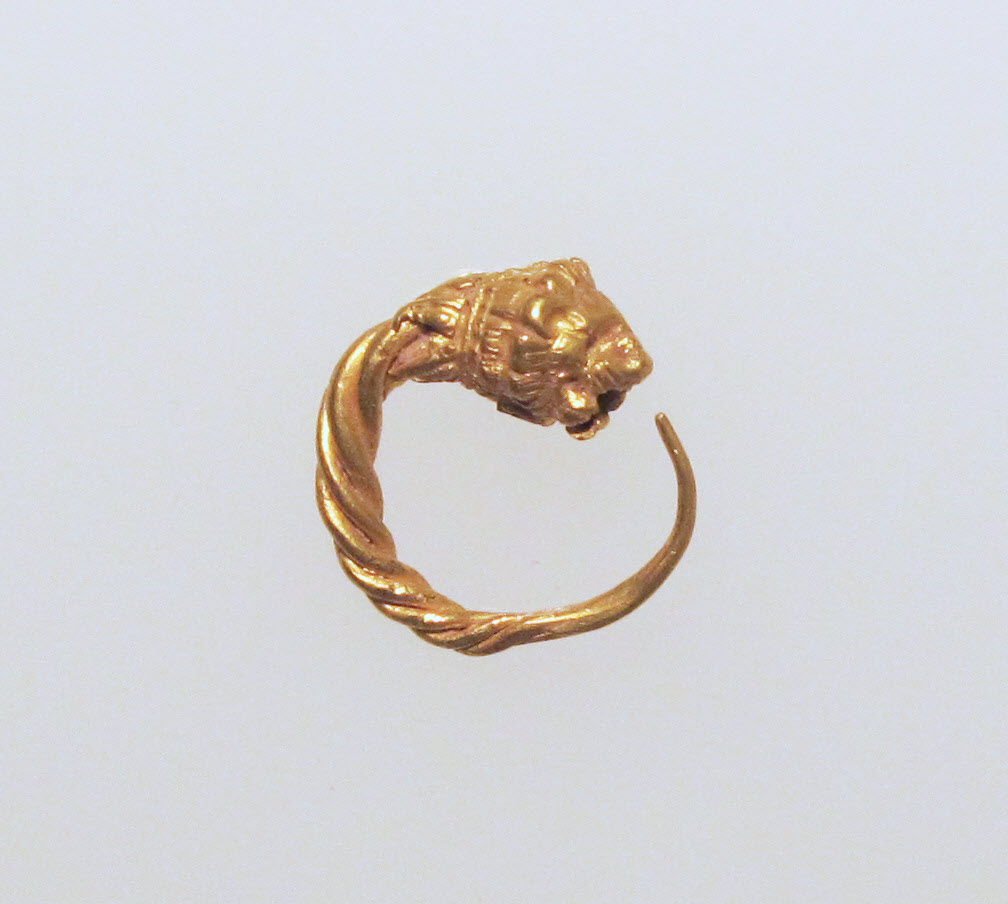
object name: earring with head of lion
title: Gold earring with head of a lion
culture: greek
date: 400-201 BCE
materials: gold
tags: lions